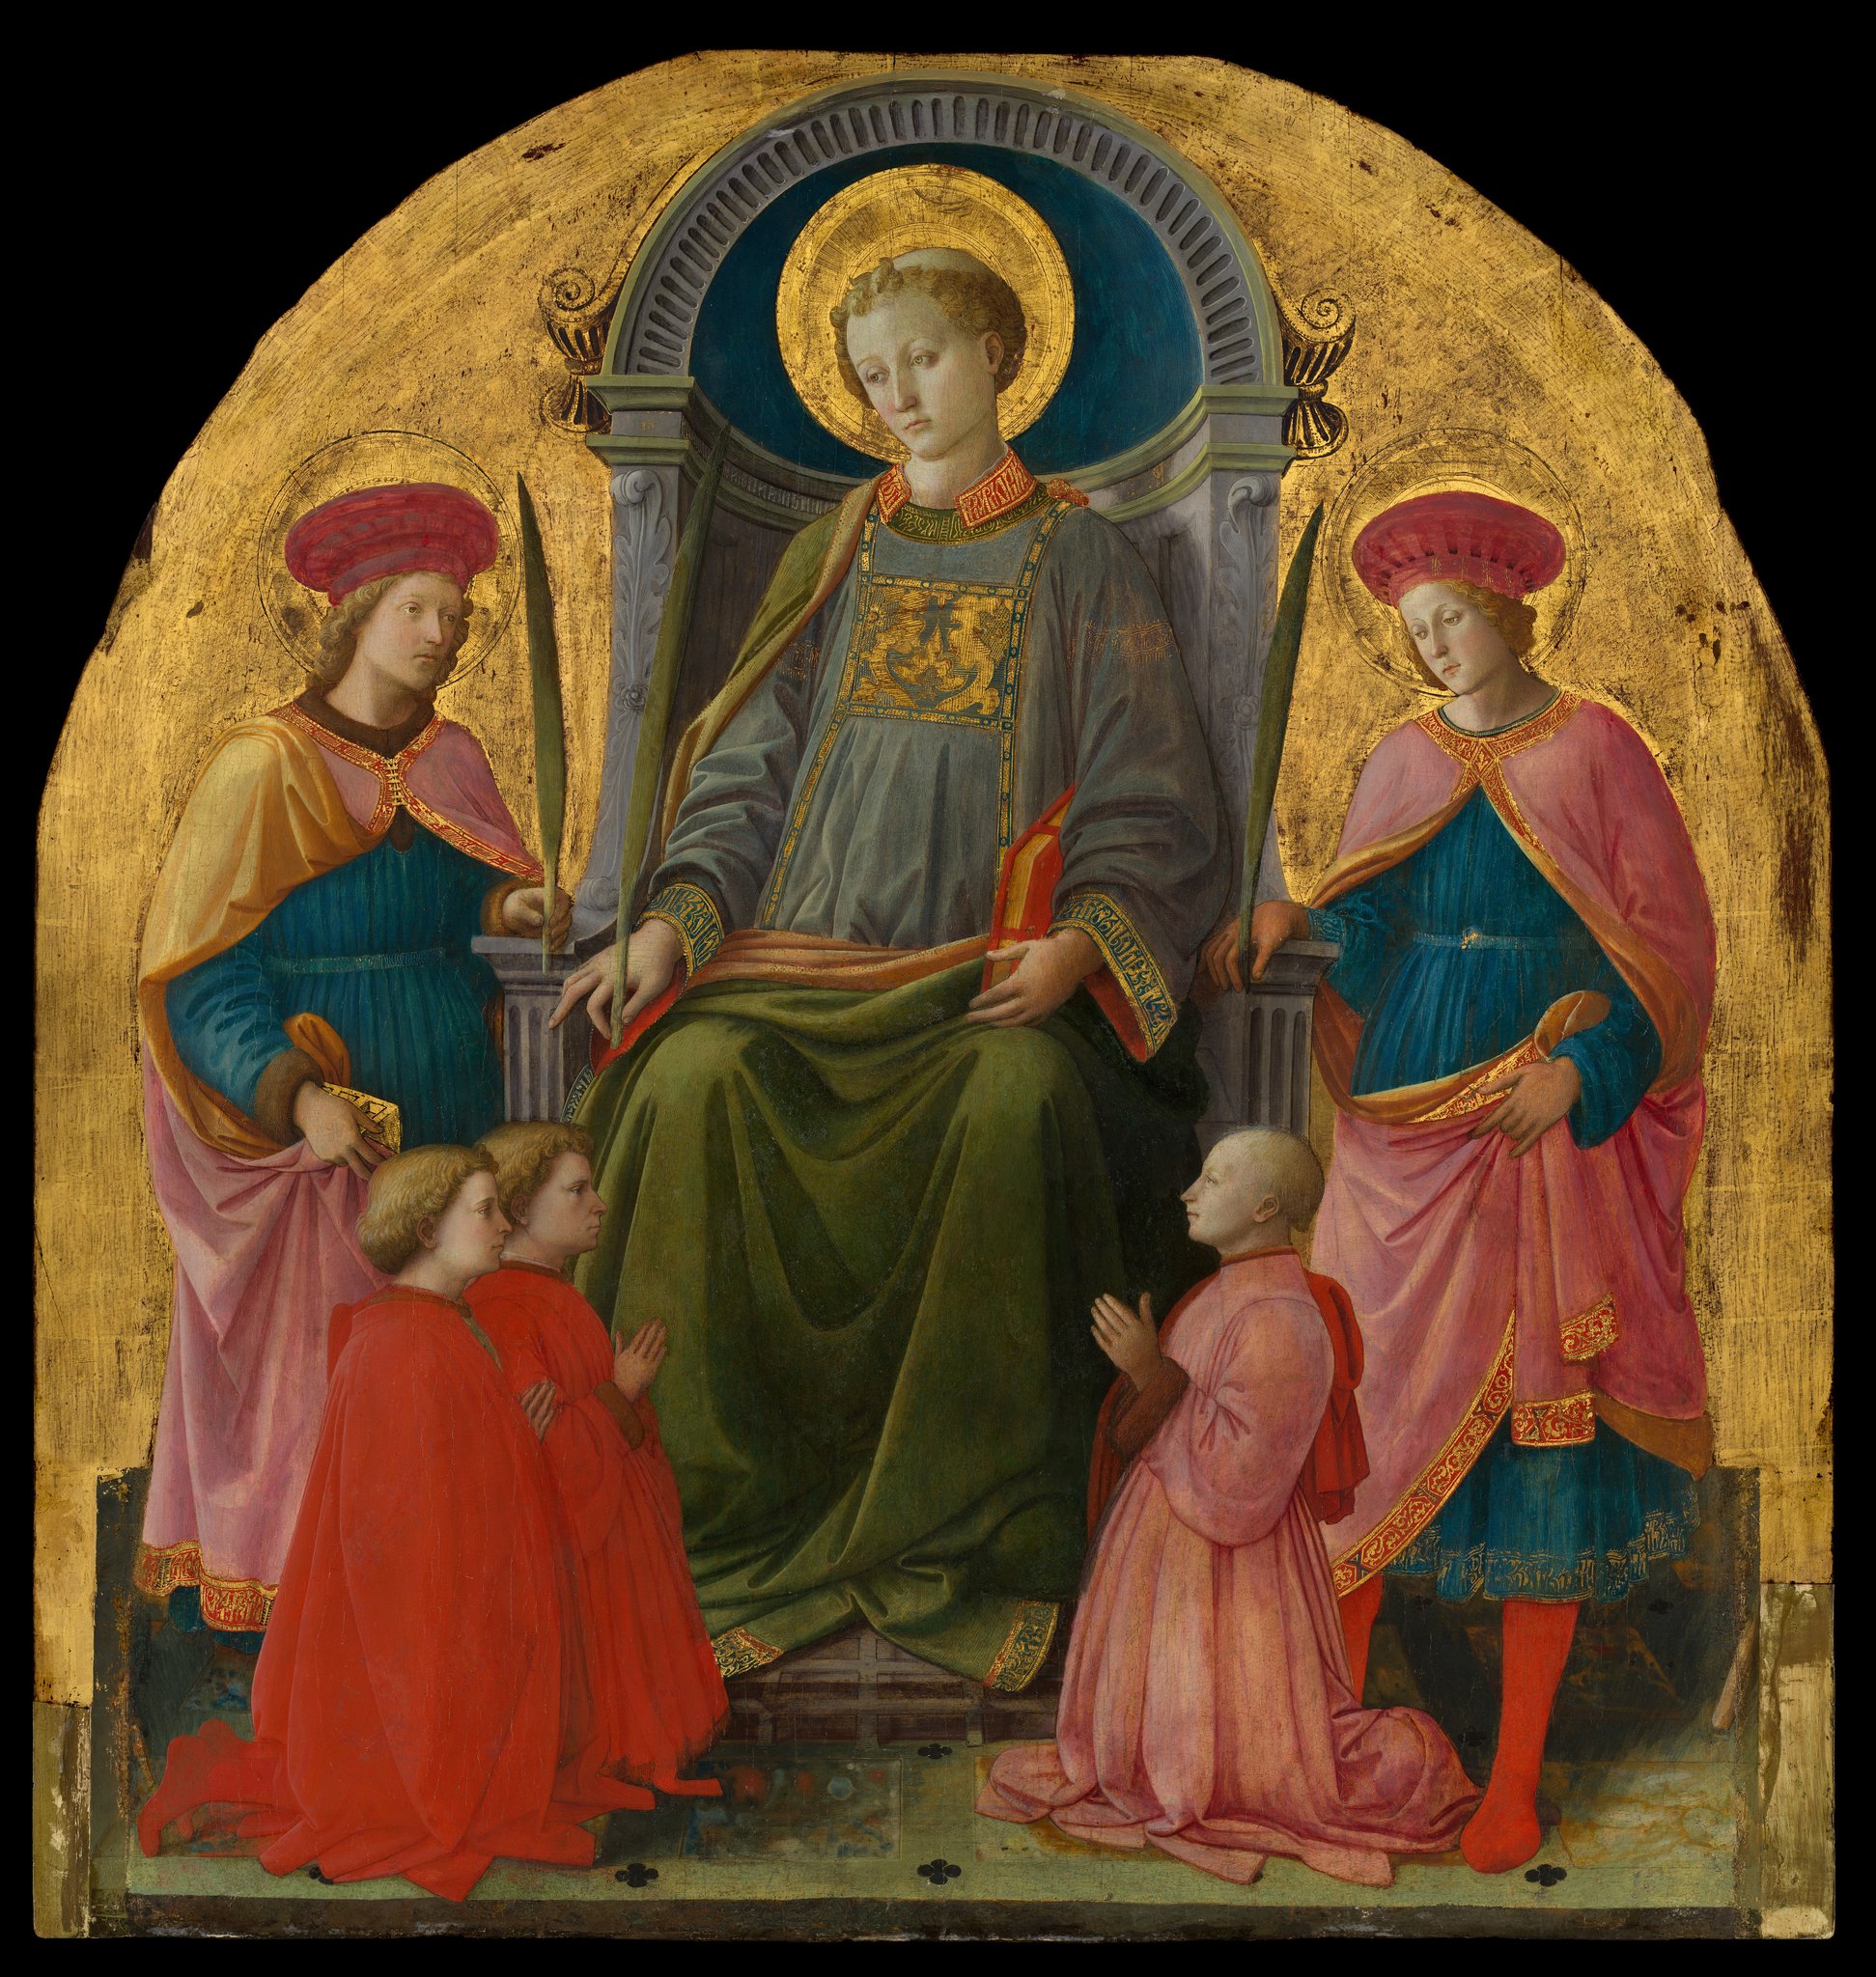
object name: painting, altarpiece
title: Saint Lawrence Enthroned with Saints and Donors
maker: fra filippo lippi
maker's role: artist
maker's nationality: italian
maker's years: 1406-1469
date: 1440-1449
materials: gold leaf, paint, wood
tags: men,saint lawrence,saints